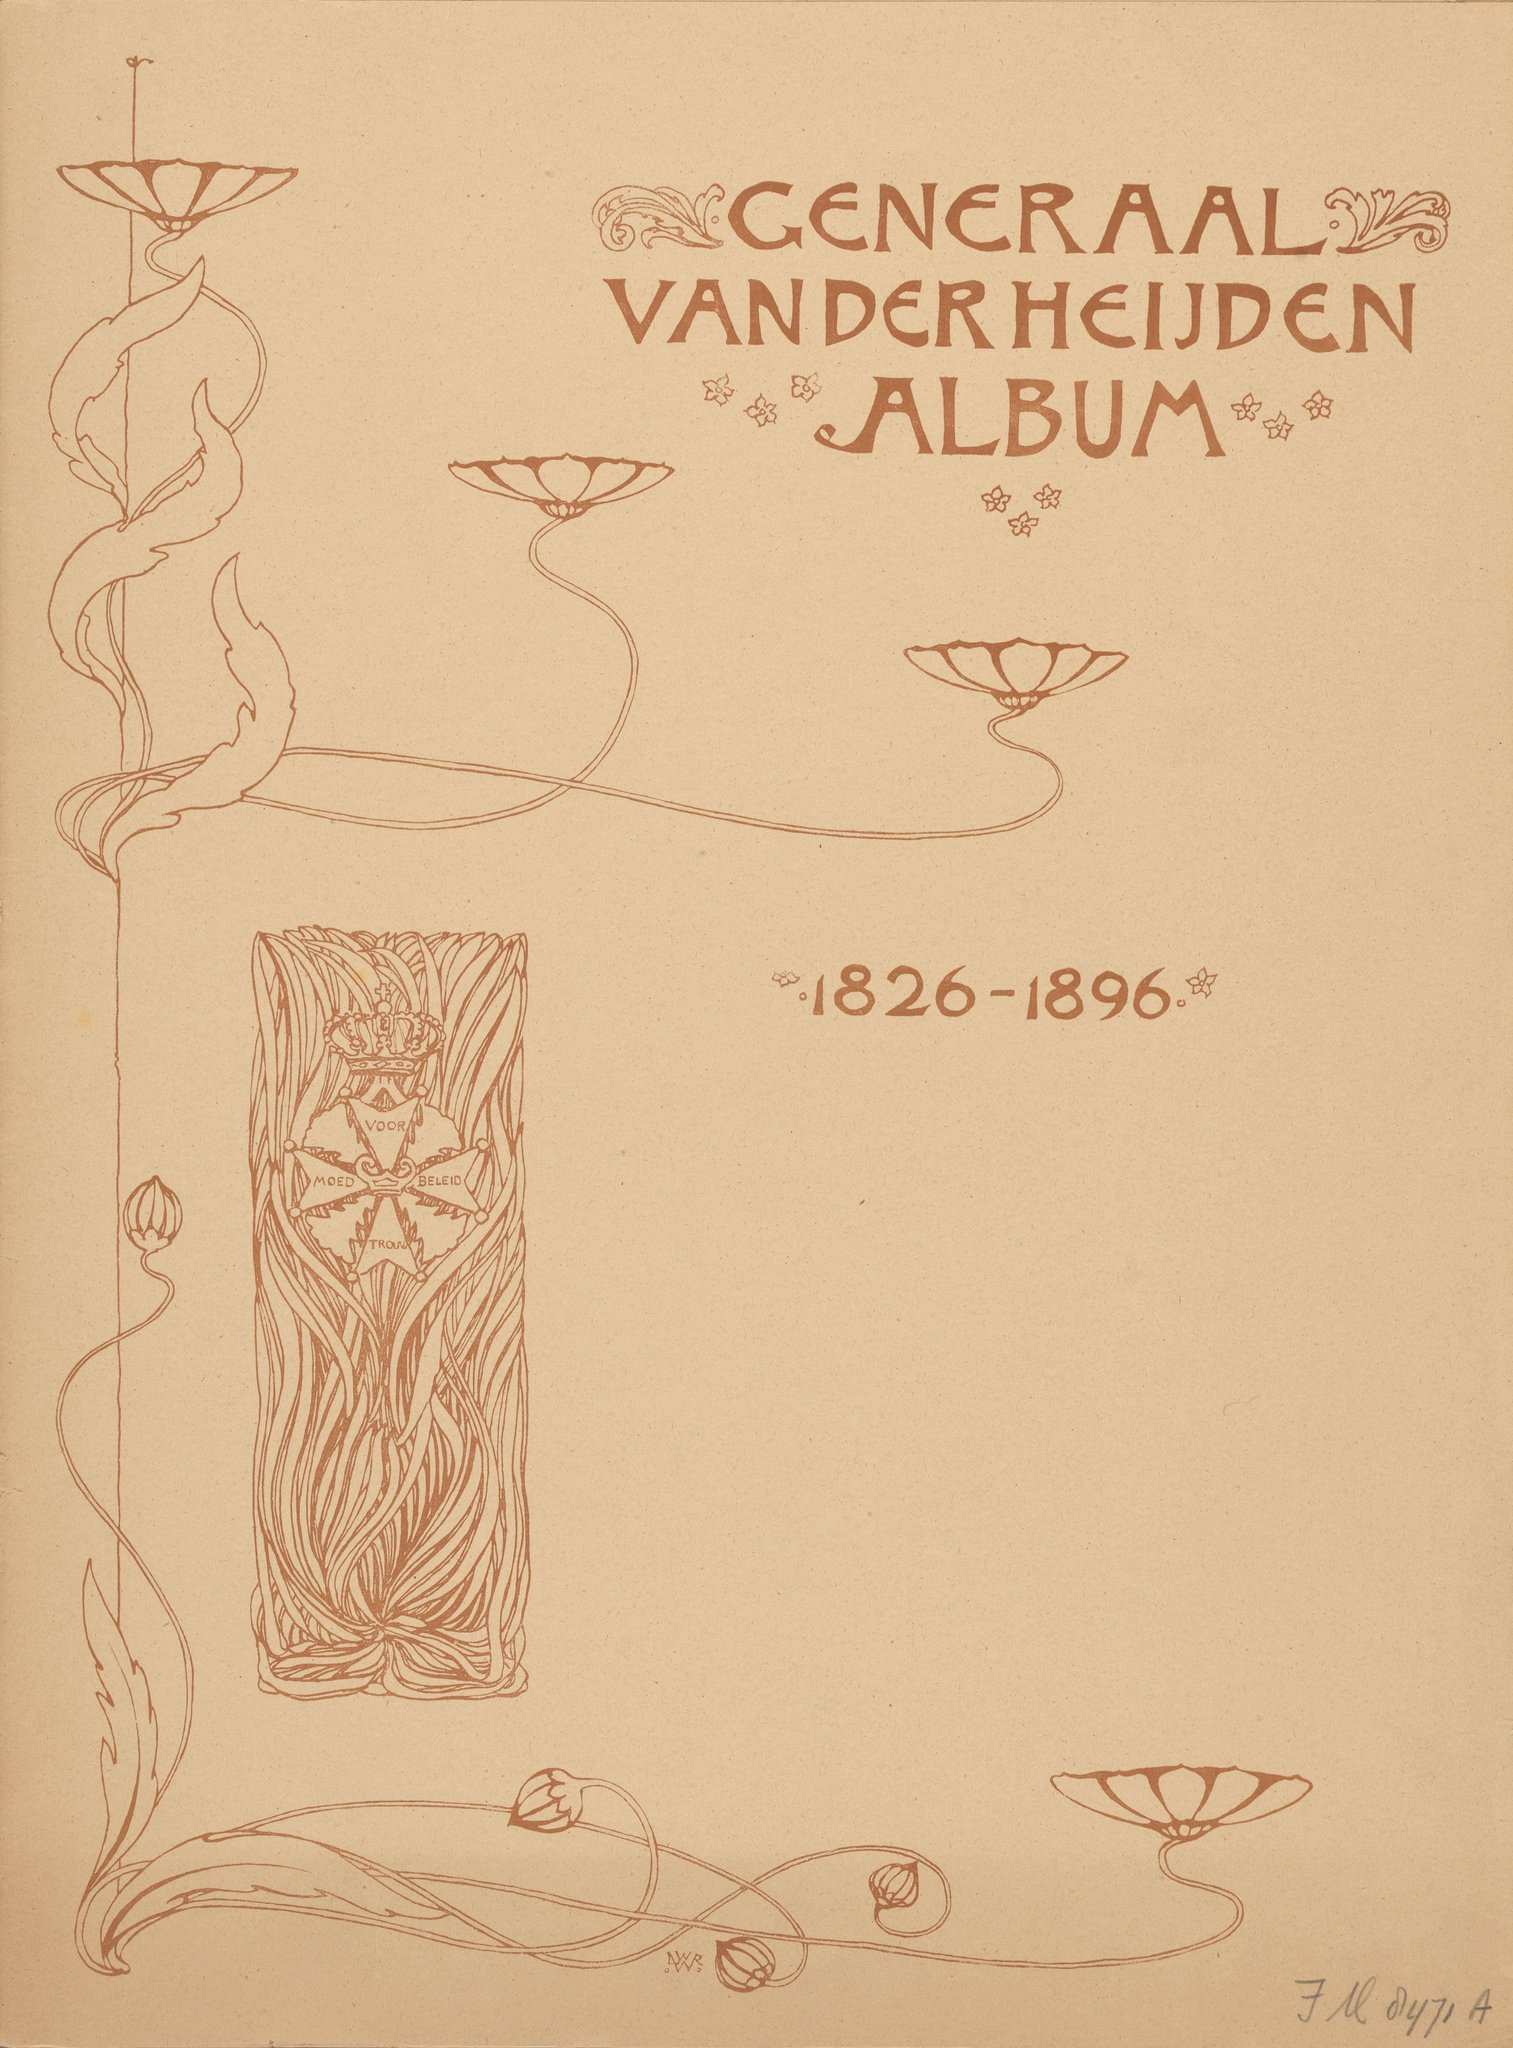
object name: print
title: Generaal Van Der Heijden Album. 1826-1896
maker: Anonymous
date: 1896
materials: paper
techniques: printing, lithograph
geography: amsterdam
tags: medals and other marks of military honour, dutch east indies, the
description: Buitenste omslag versierd met florale motieven en de Militaire Willemsorde voor een blad van zestien bladzijden met tekst. Album uitgegeven ter gelegenheid van de zeventigste verjaardag van luitenant-generaal Karel van der Heijden, 1896. Uitgave van de Amsterdamsche Courant.